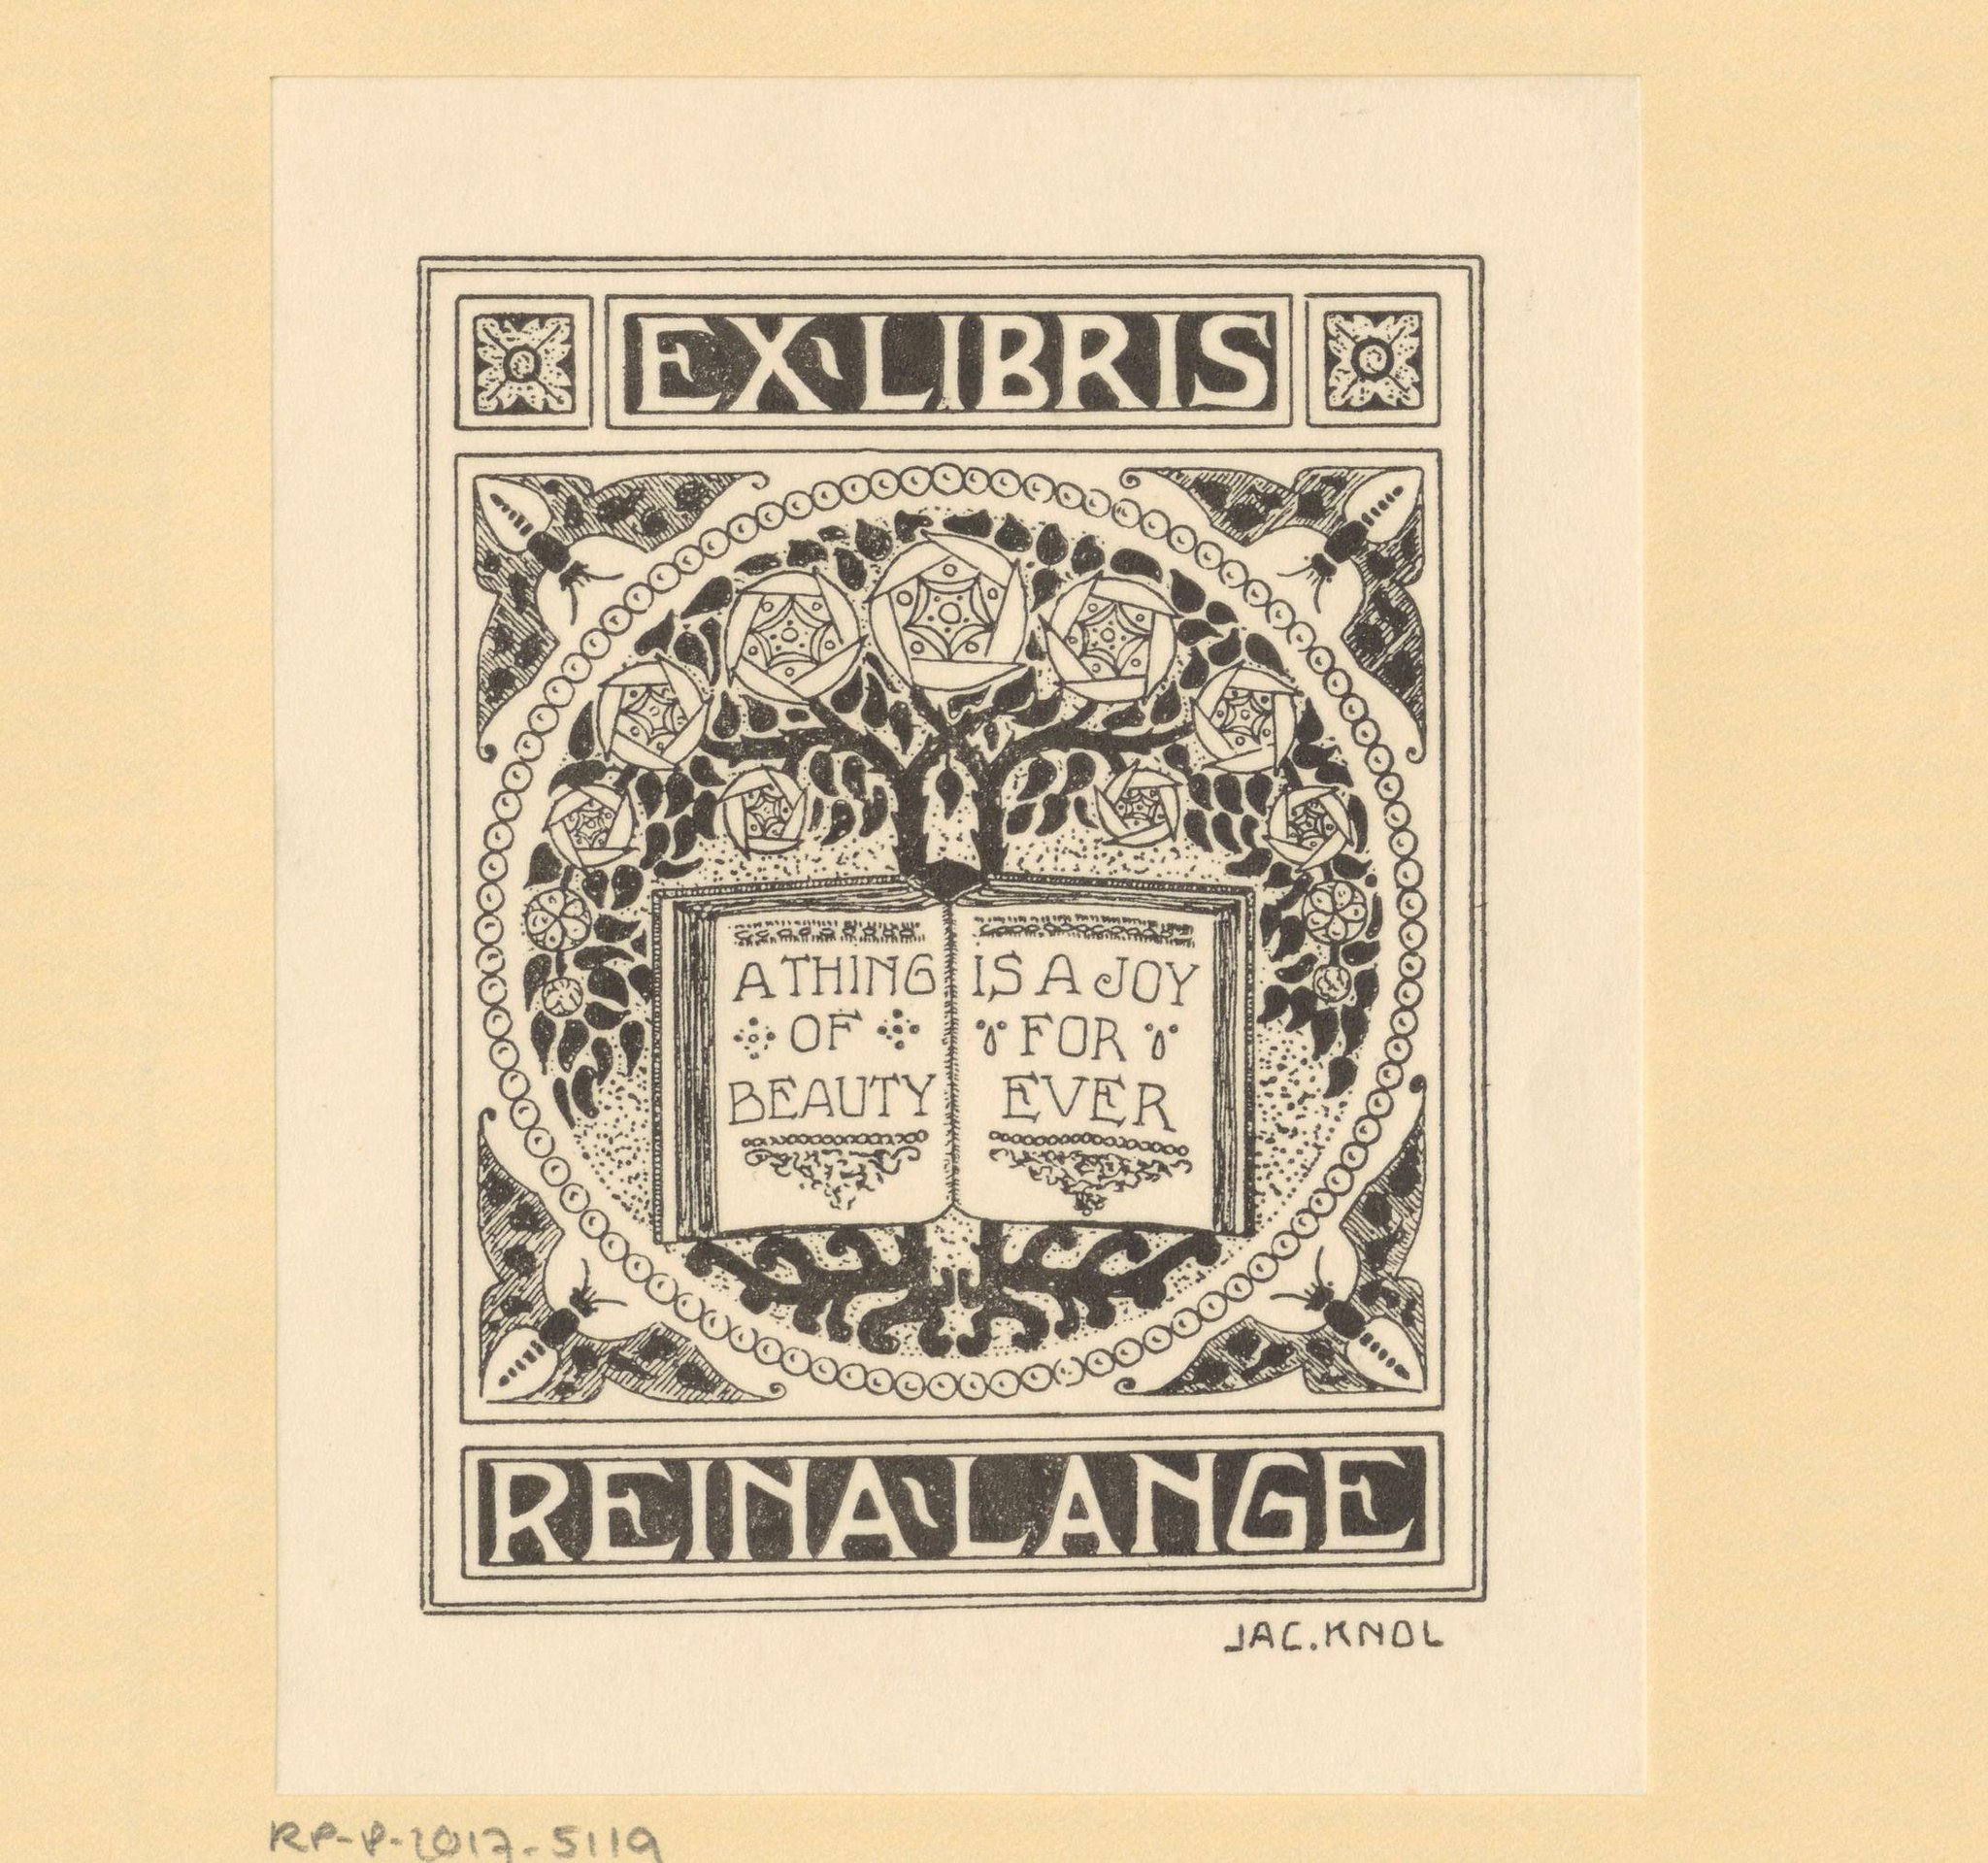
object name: bookplate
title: A thing of beauty is a joy forever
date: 1923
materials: paper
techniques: printing block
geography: netherlands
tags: shrubs: rose-bush, book, insects: butterfly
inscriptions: workshop stamp: ‘Cliche-druk 1923 / ontw. Jac.B. Knol’